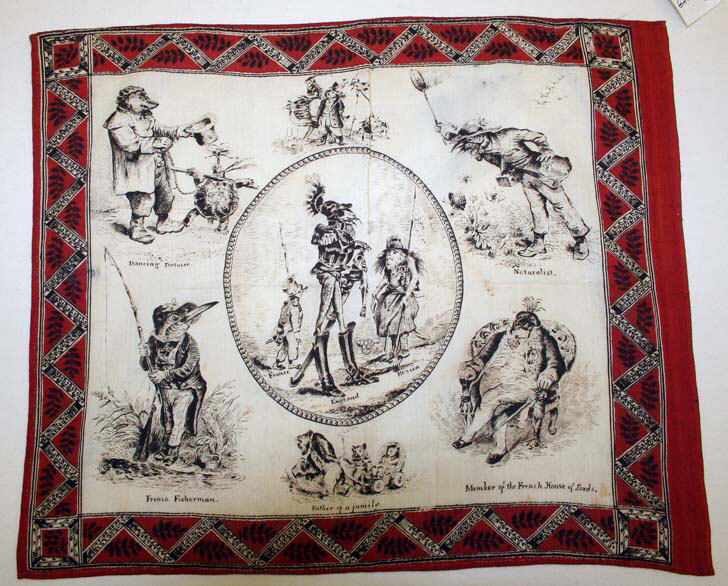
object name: handkerchief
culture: british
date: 1801-1900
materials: cotton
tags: satire